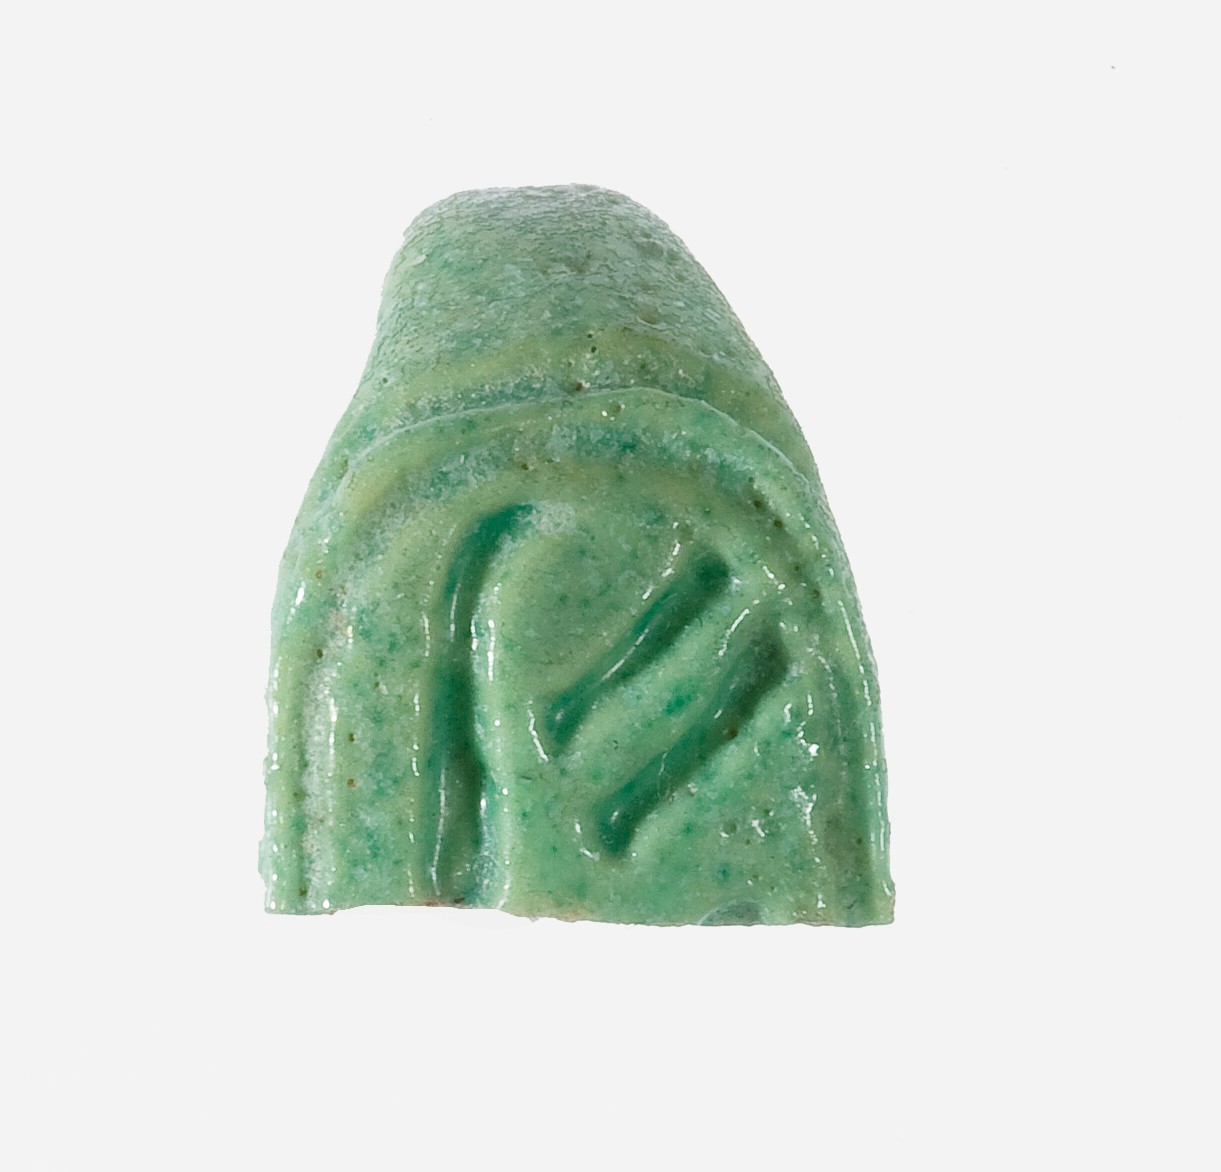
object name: ring fragment, tiy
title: Ring Fragment With the Name Tiye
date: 1390-1352 BCE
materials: faience